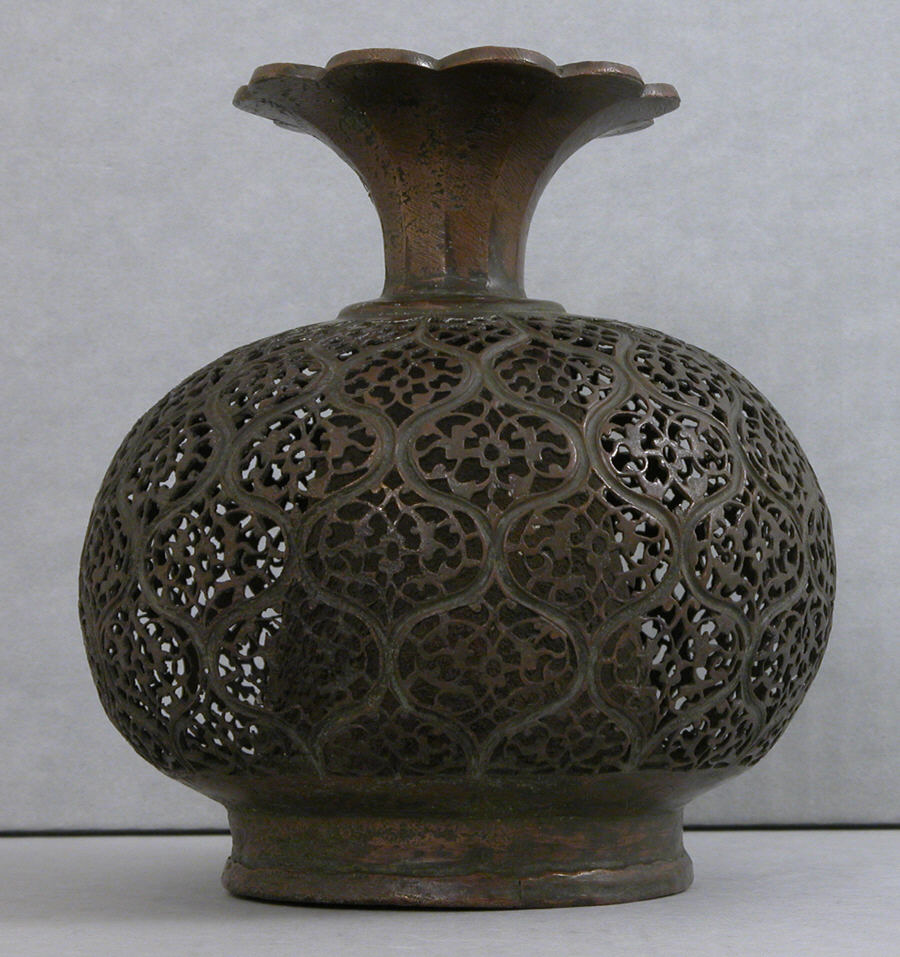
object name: vase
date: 1601-1700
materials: bronze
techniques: casting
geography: india